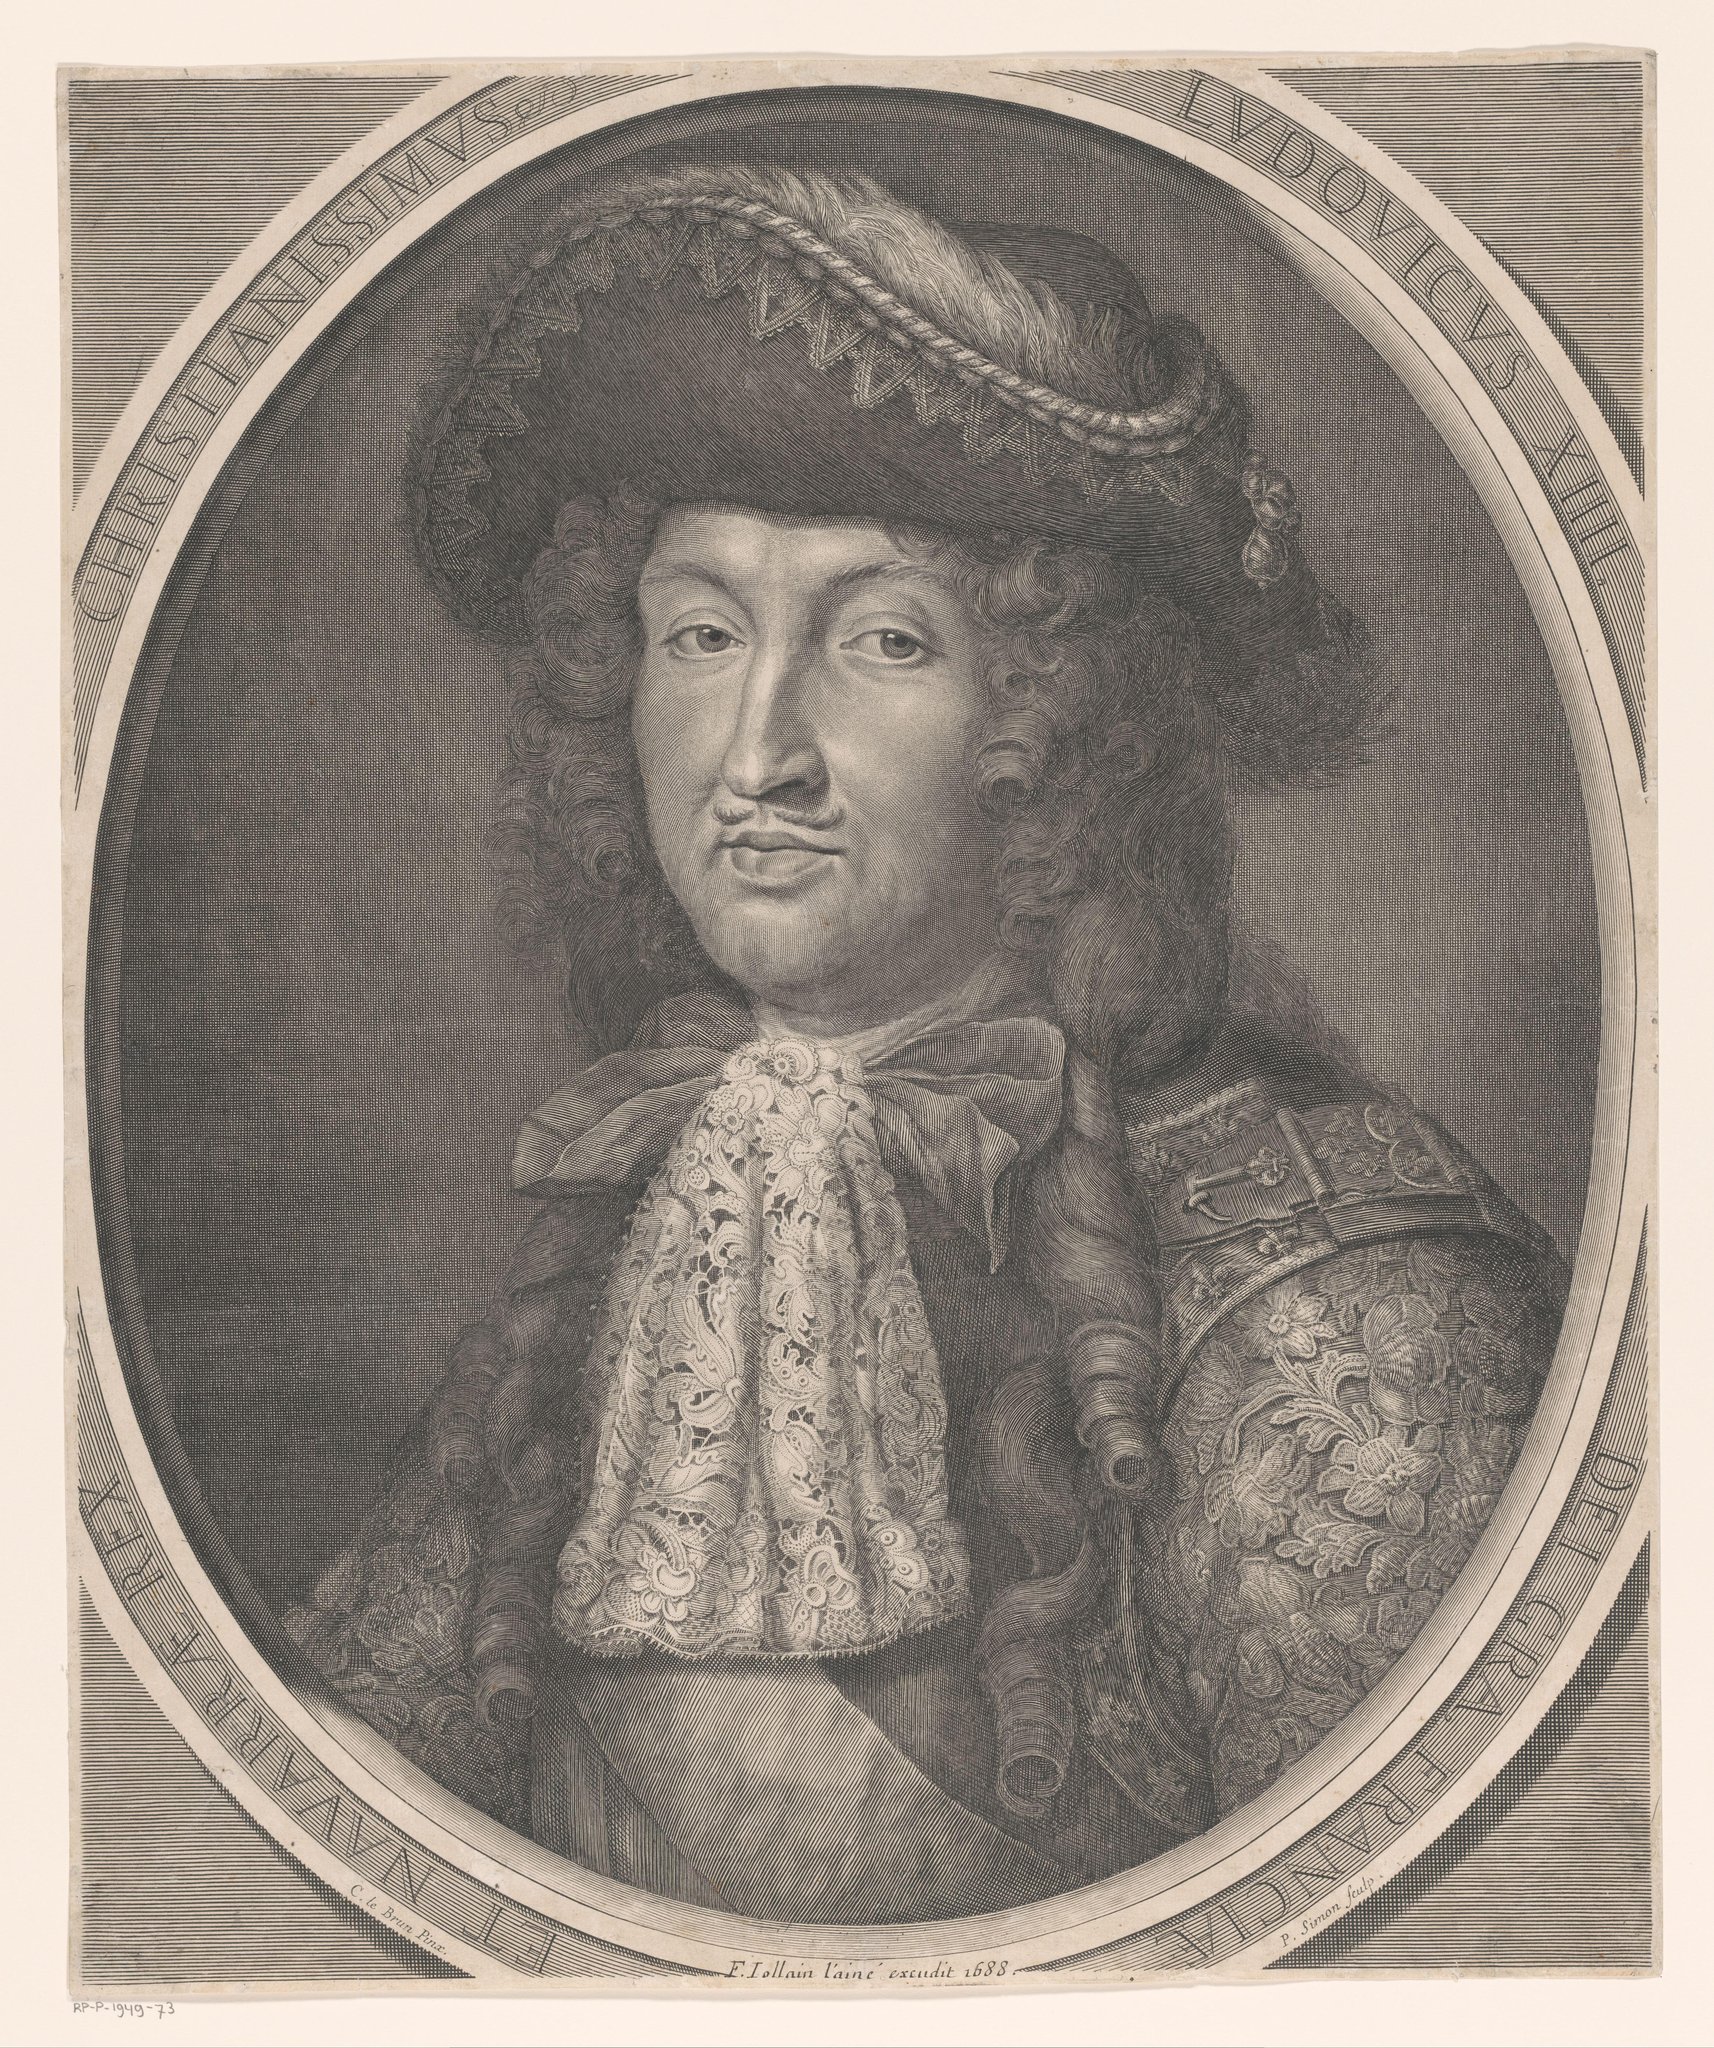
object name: print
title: Portret van Lodewijk XIV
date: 1688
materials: paper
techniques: engraving, etching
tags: lodewijk xiv (koning van frankrijk), historical persons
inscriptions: collector's mark: Lugt 2228